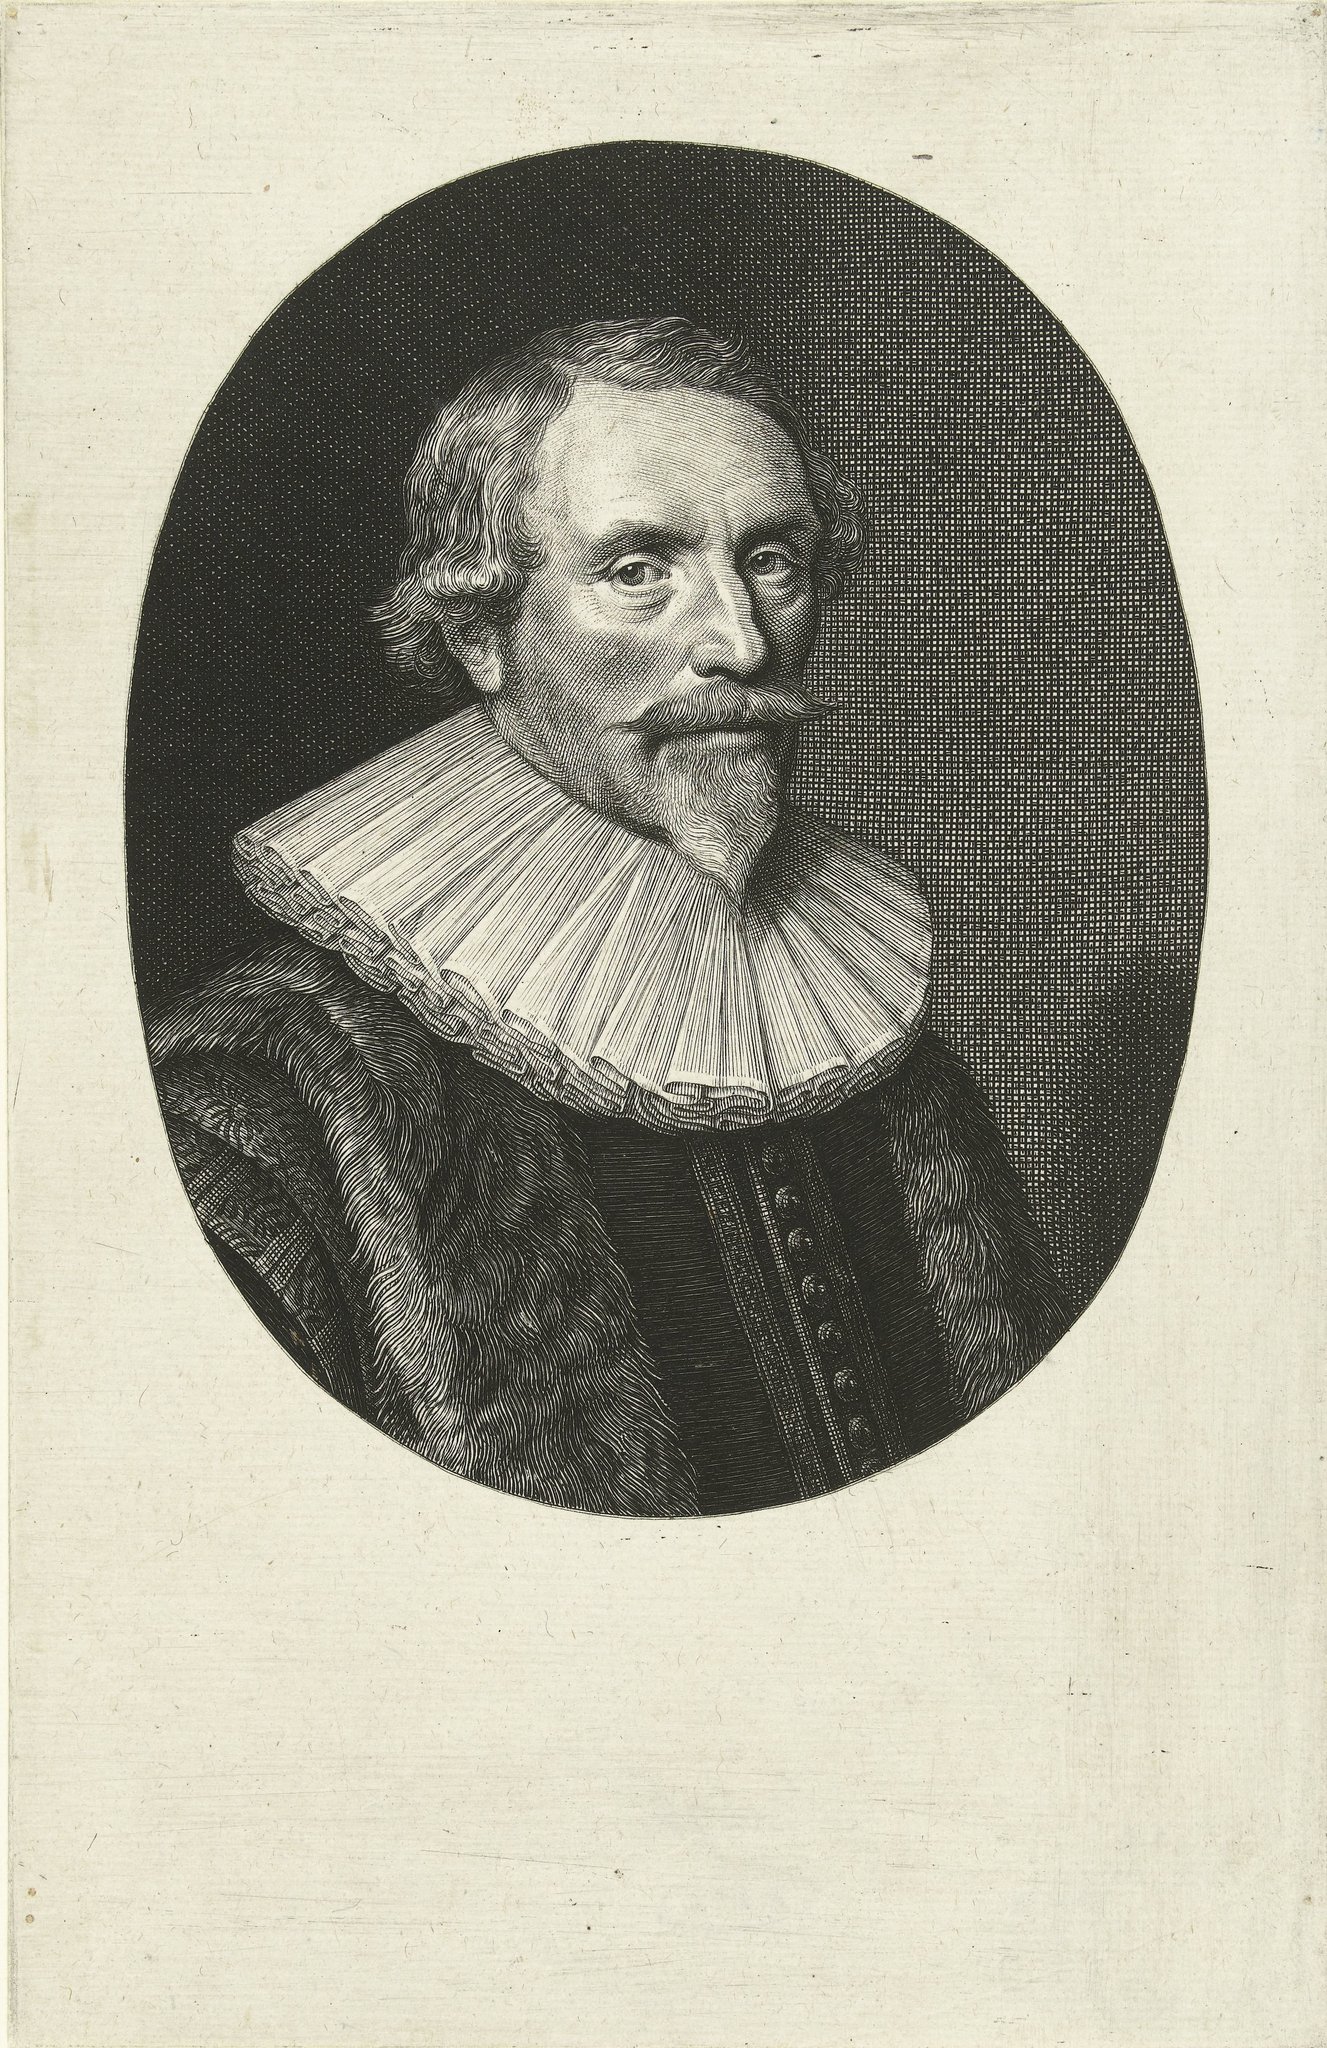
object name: print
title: Portret van Jacob Cats op 57-jarige leeftijd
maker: willem jacobsz delff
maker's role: draughtsman, print maker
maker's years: 1580-1638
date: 1635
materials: paper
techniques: engraving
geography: delft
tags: the hague, jacob cats (1577-1660), portrait of a writer, neck-gear: collar (+ men's clothes)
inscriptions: collector's mark: Lugt 963, collector's mark: Lugt 2228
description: Portret van Jacob Cats op 57-jarige leeftijd, borststuk met plooikraag en toga in ovaal.